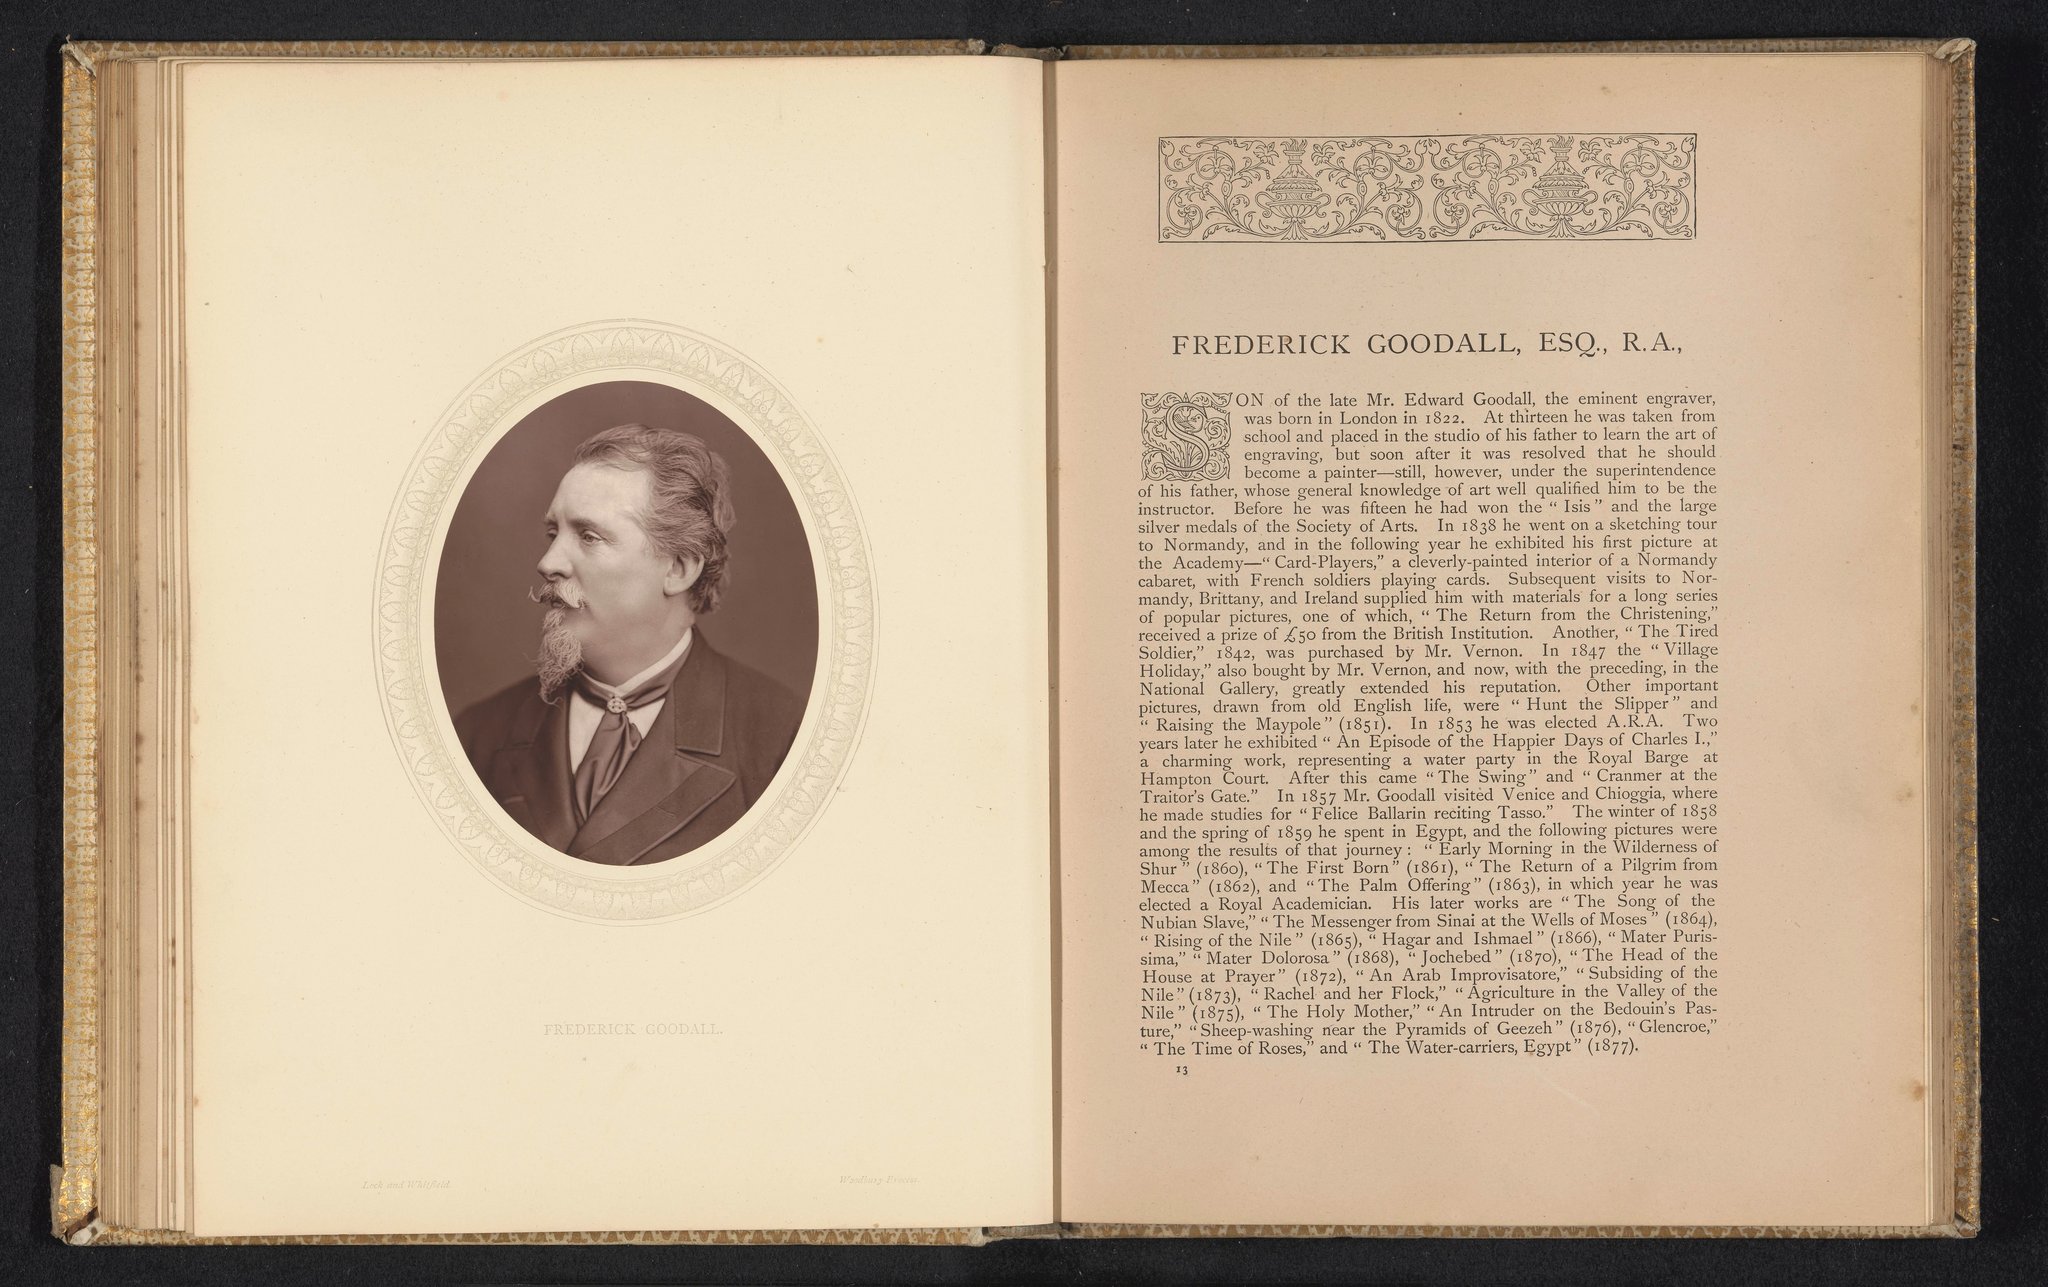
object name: page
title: Frederick Goodall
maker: Anonymous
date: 1873-1878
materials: paper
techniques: woodburytype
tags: painter, frederick goodall, portrait, self-portrait of painter, historical persons (portraits and scenes from the life) (+ (full) bust portrait)